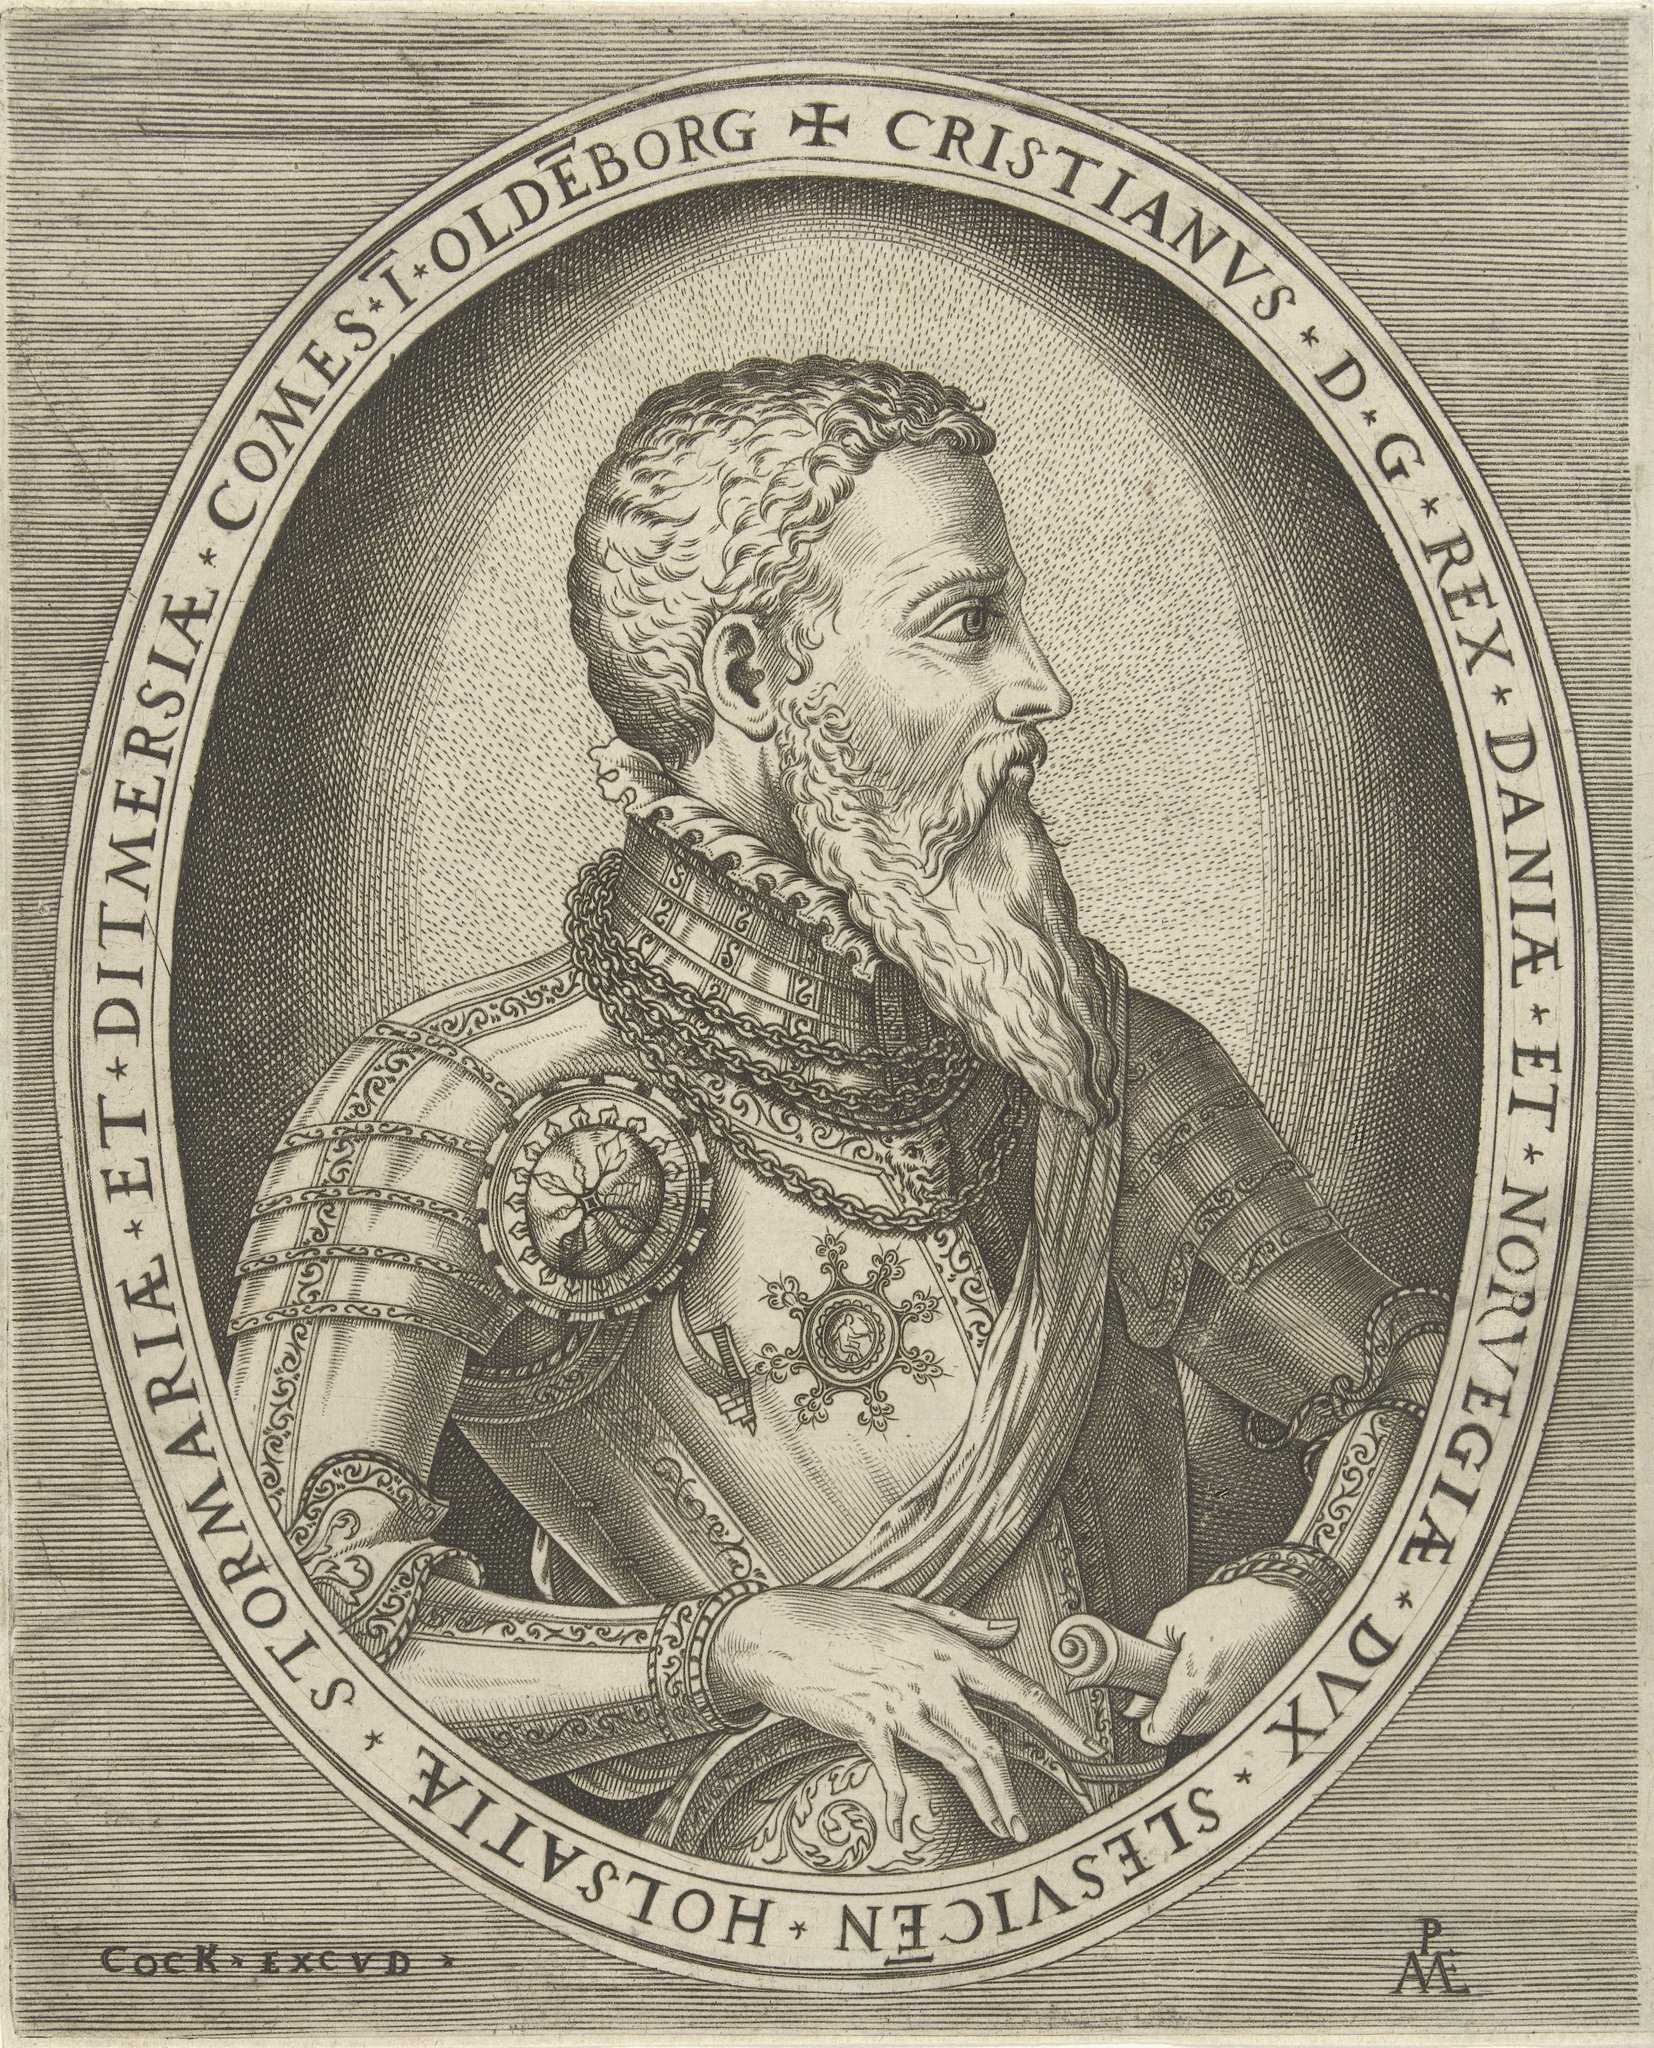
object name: print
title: Portret van Christiaan III, koning van Denemarken en Noorwegen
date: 1540-1559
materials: paper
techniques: engraving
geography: antwerp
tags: armour, necklace (+ men's clothes)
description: Portret ten halven lijve naar rechts van Christiaan III, koning van Denemarken en Noorwegen in een ovaal met zijn naam en titel in het Latijn..